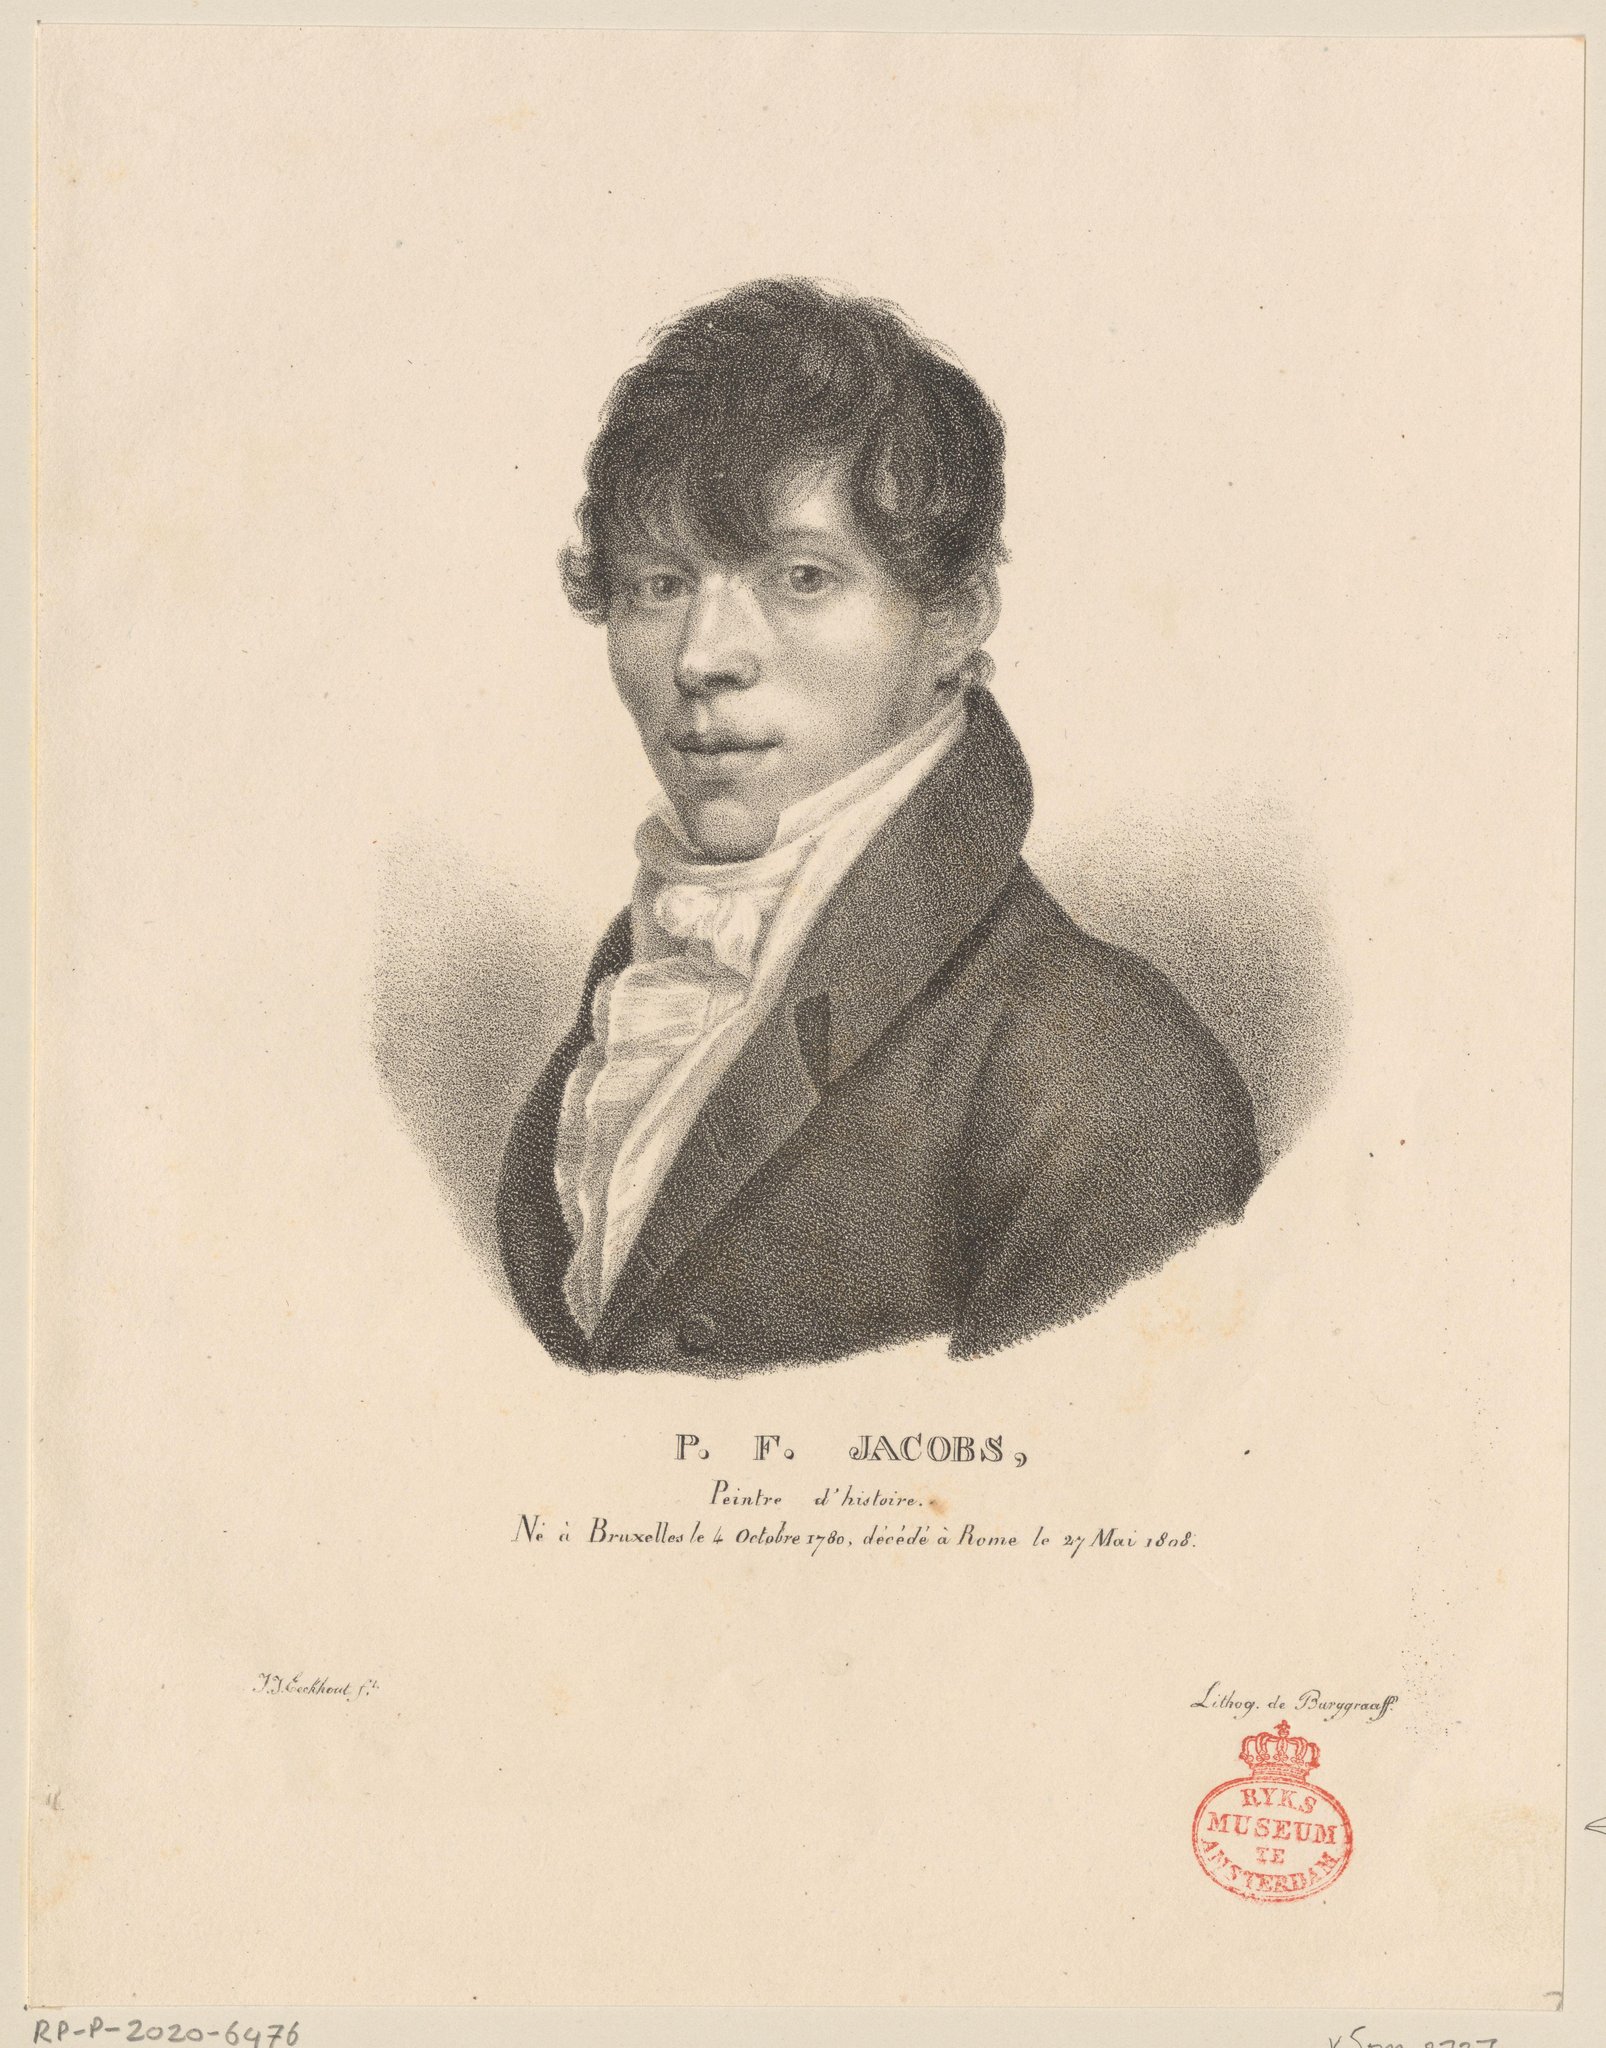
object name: print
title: Portret van Pieter Frans Jacobs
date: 1822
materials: paper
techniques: lithograph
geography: brussels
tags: brussels, rome, painter, historical persons, portrait, self-portrait of painter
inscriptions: collector's mark: Lugt 12